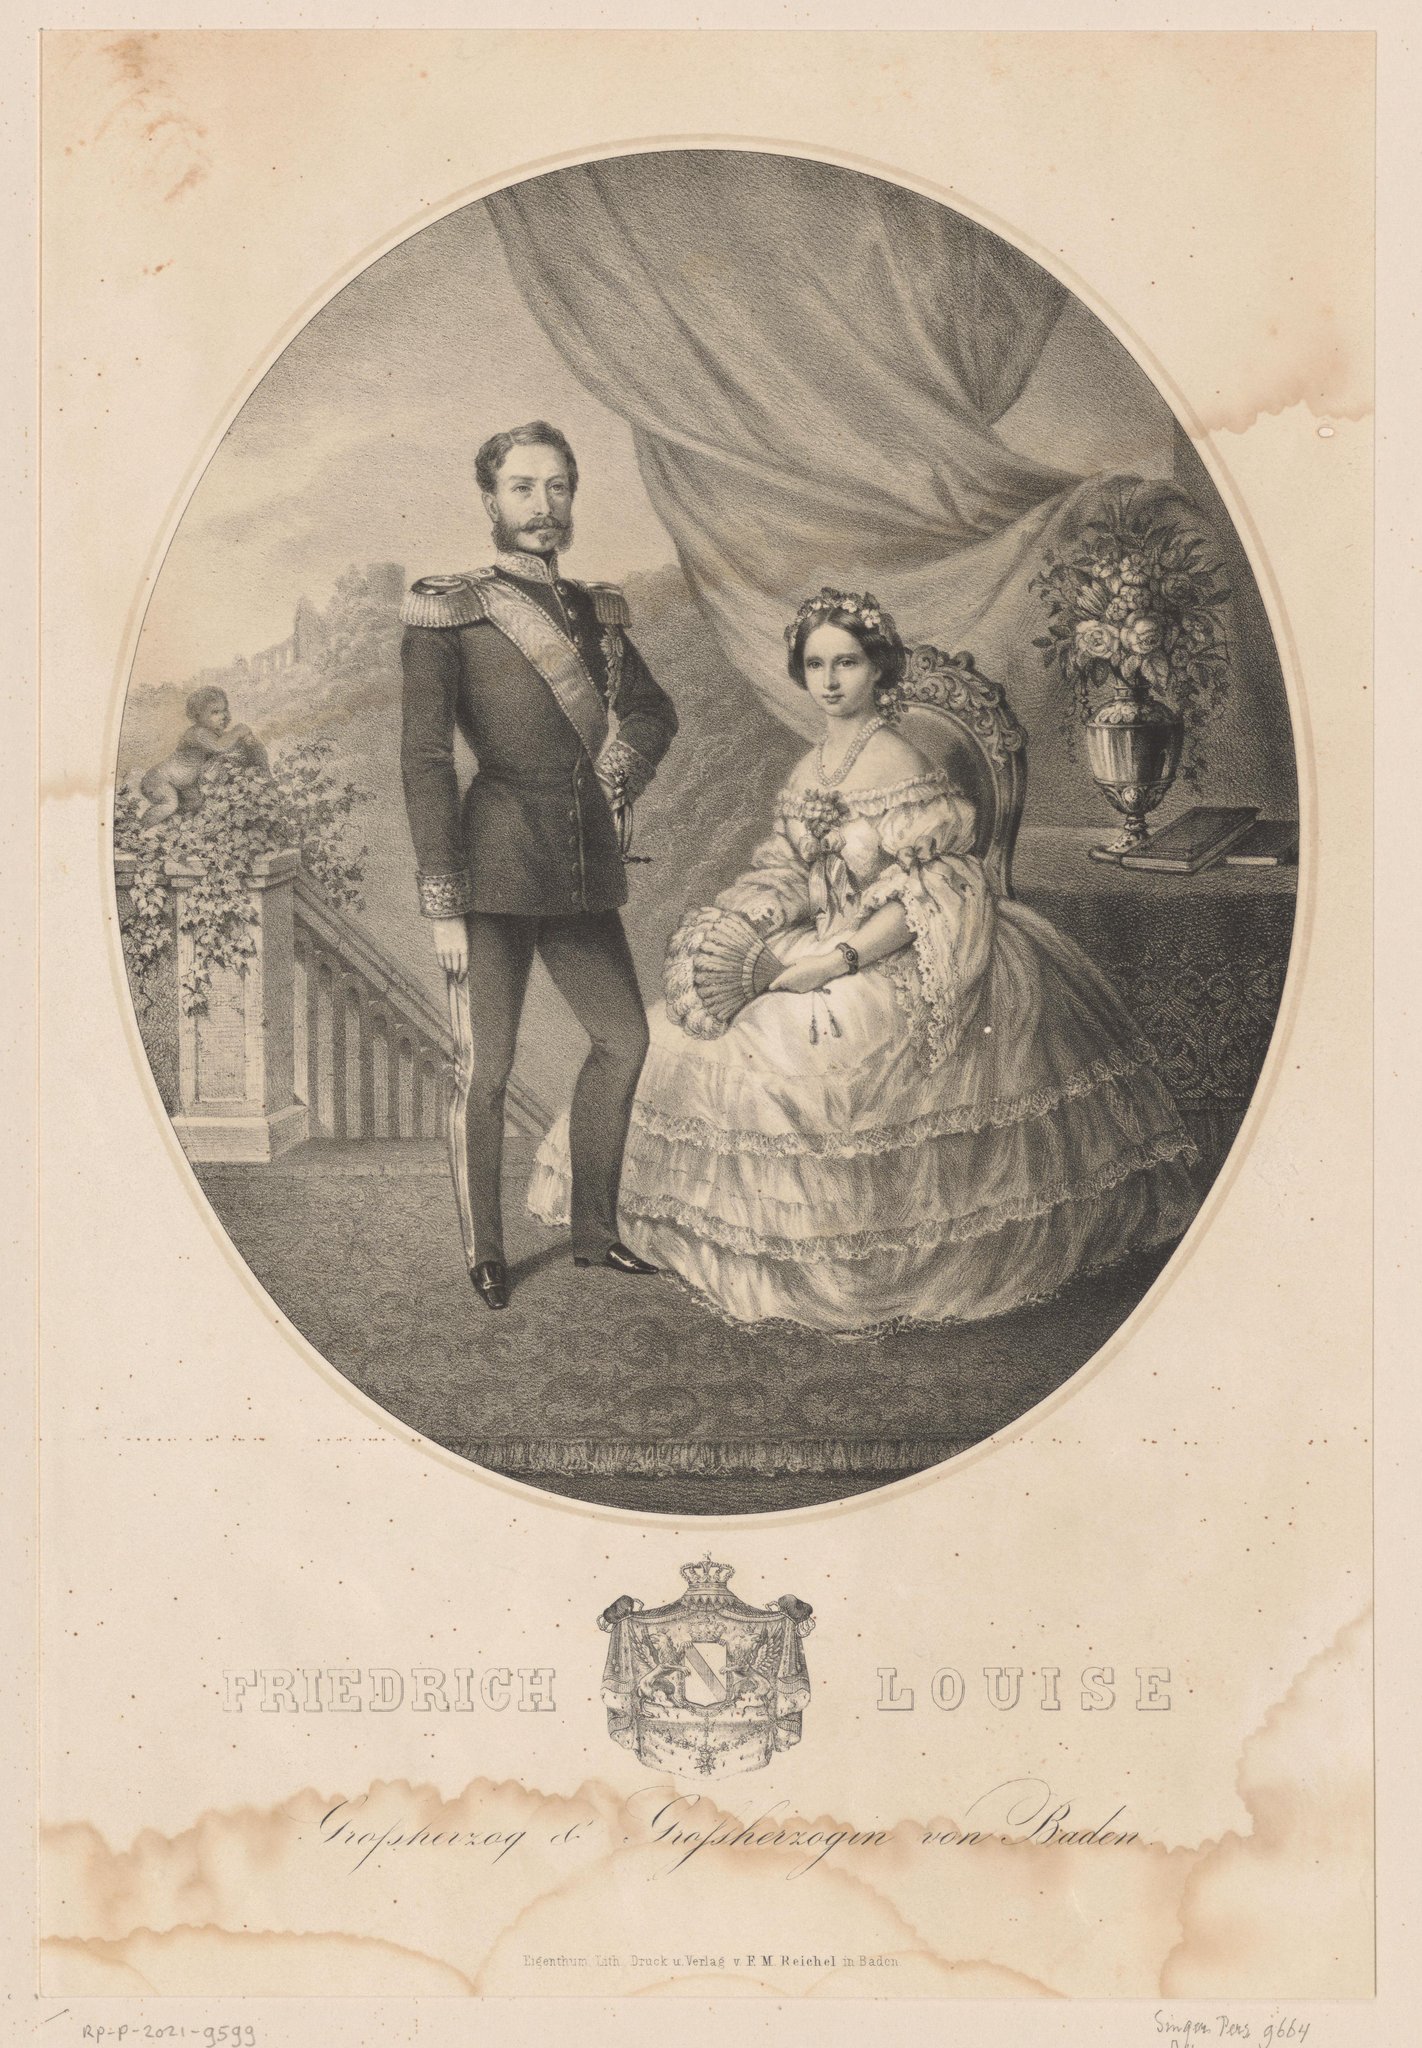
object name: print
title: Dubbelportret Frederik I van Baden en Louise Marie Elisabeth van Pruisen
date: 1856-1858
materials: paper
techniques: lithograph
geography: baden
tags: berlin, coat of arms (symbol of sovereignty), historical persons - bb - woman, historical persons, flowers in a vase